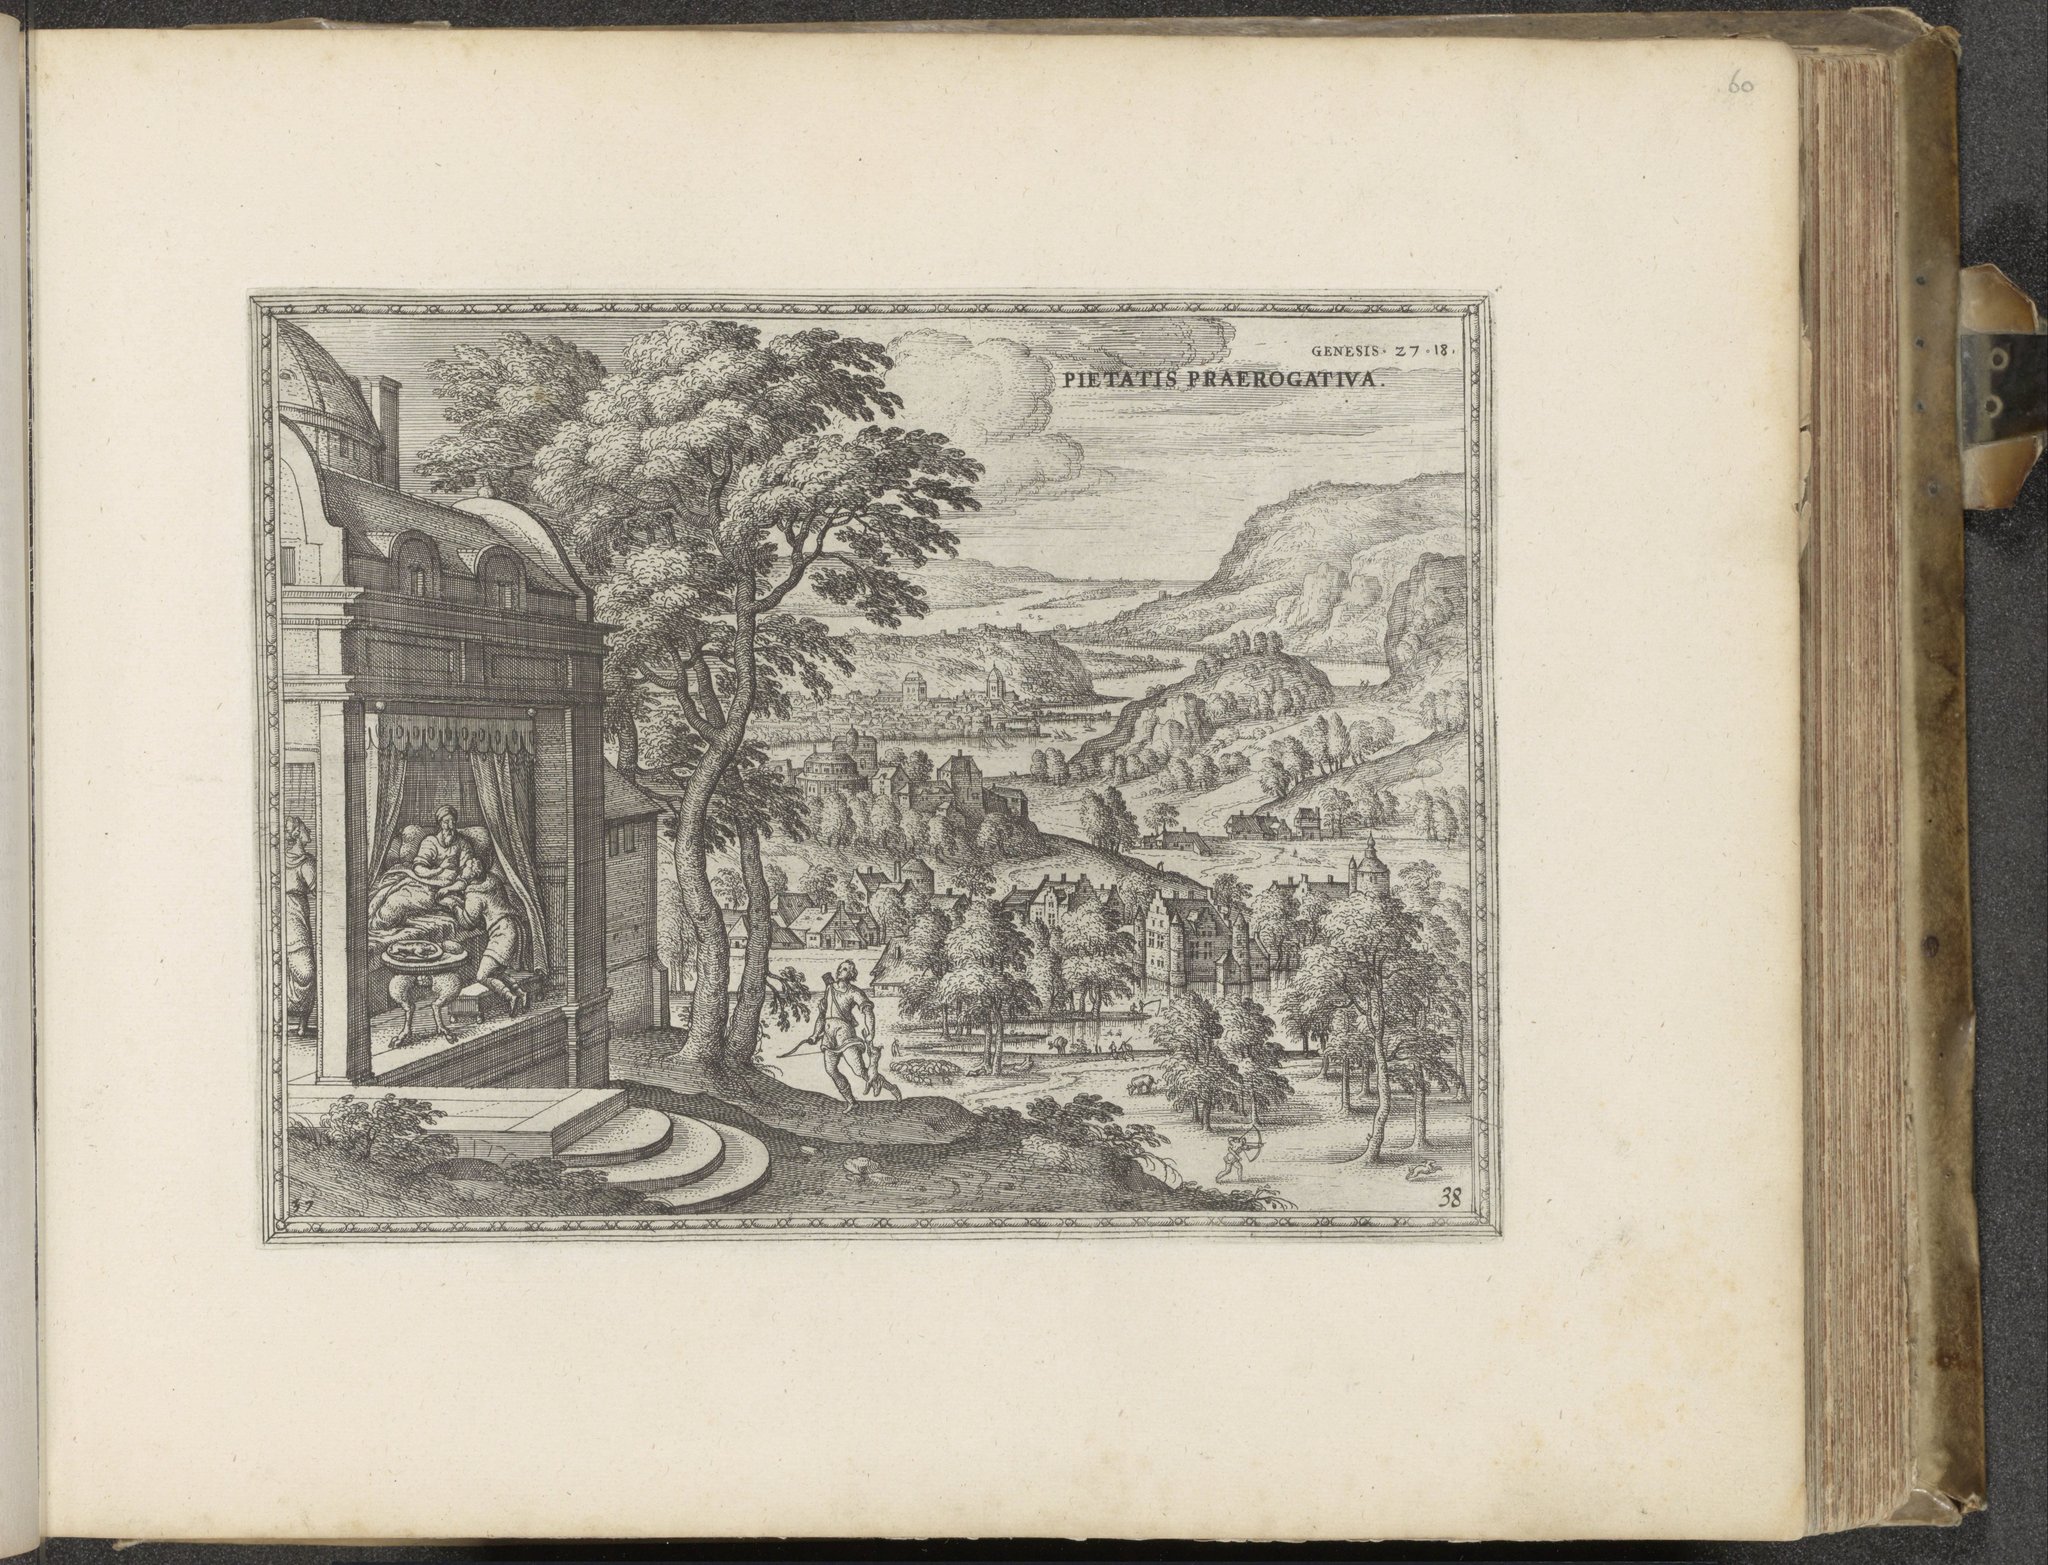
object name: print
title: Imagines et figurae bibliorum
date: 1582-1593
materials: paper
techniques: etching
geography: amsterdam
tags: river, isaac lying in bed blesses jacob who, disguised in esau's clothes, brings food to his father; jacob's hands and neck are covered with goatskins, hunters hunting (n.b.: in 1988-1990 this notation denoted the concept of 43c11421 'hunters resting during the hunt'), old testament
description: De oude en blinde Isaak zegent Jakob vermomd als zijn broer Esau. Jakob knielt bij het bed. Links staat zijn moeder Rebekka. Rechts een rivierlandschap met Esau die terugkeert van de jacht (Gen. 27:18). De prent maakt deel uit van een album.